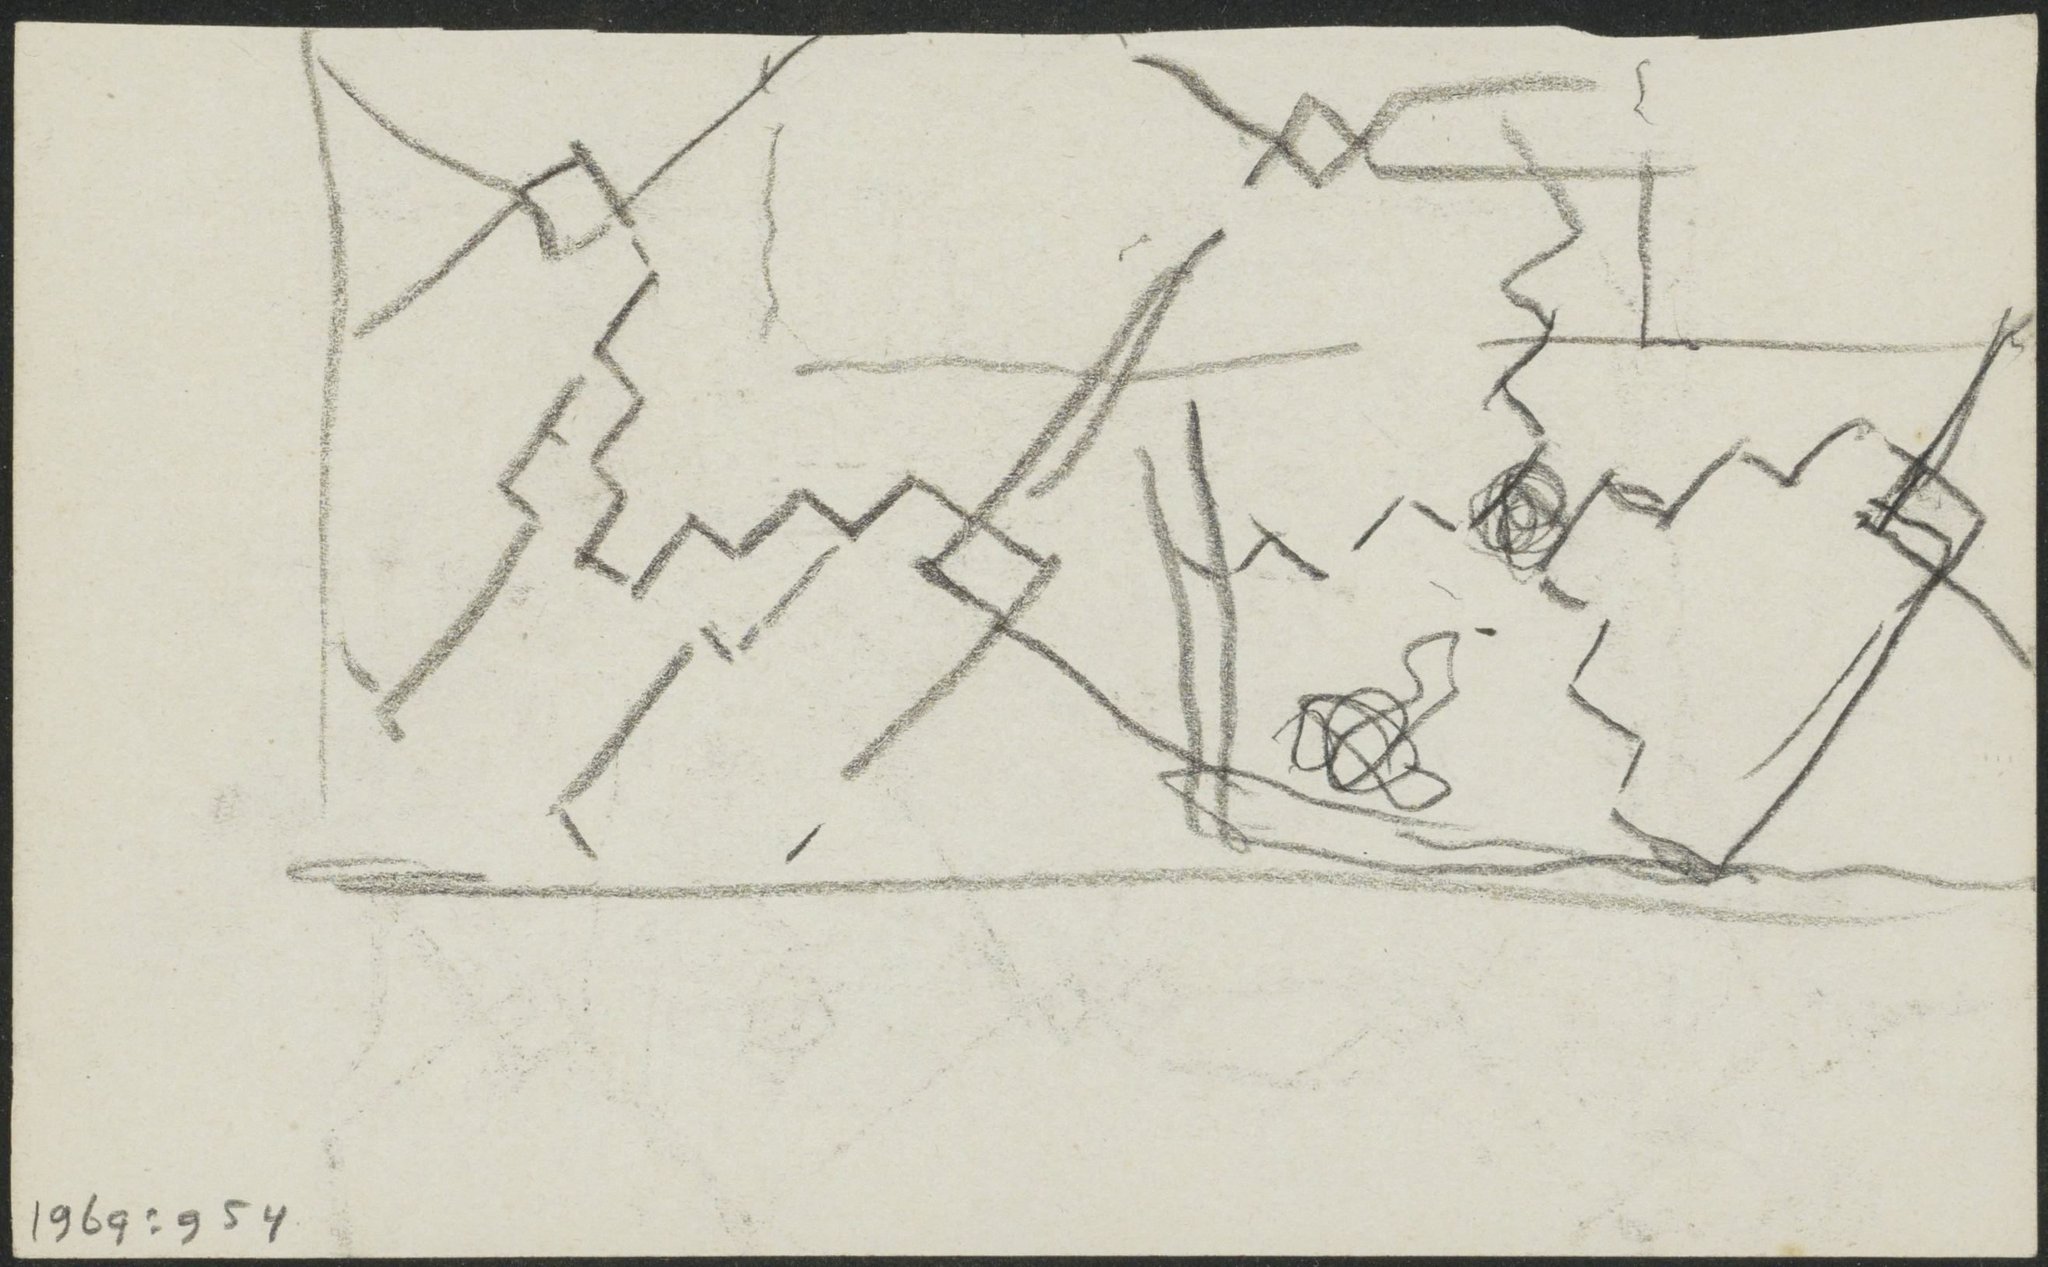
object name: drawing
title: Studies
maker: gerrit willem dijsselhof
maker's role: designer, draughtsman, print maker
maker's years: 1866-1924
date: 1876-1924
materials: chalk, paper